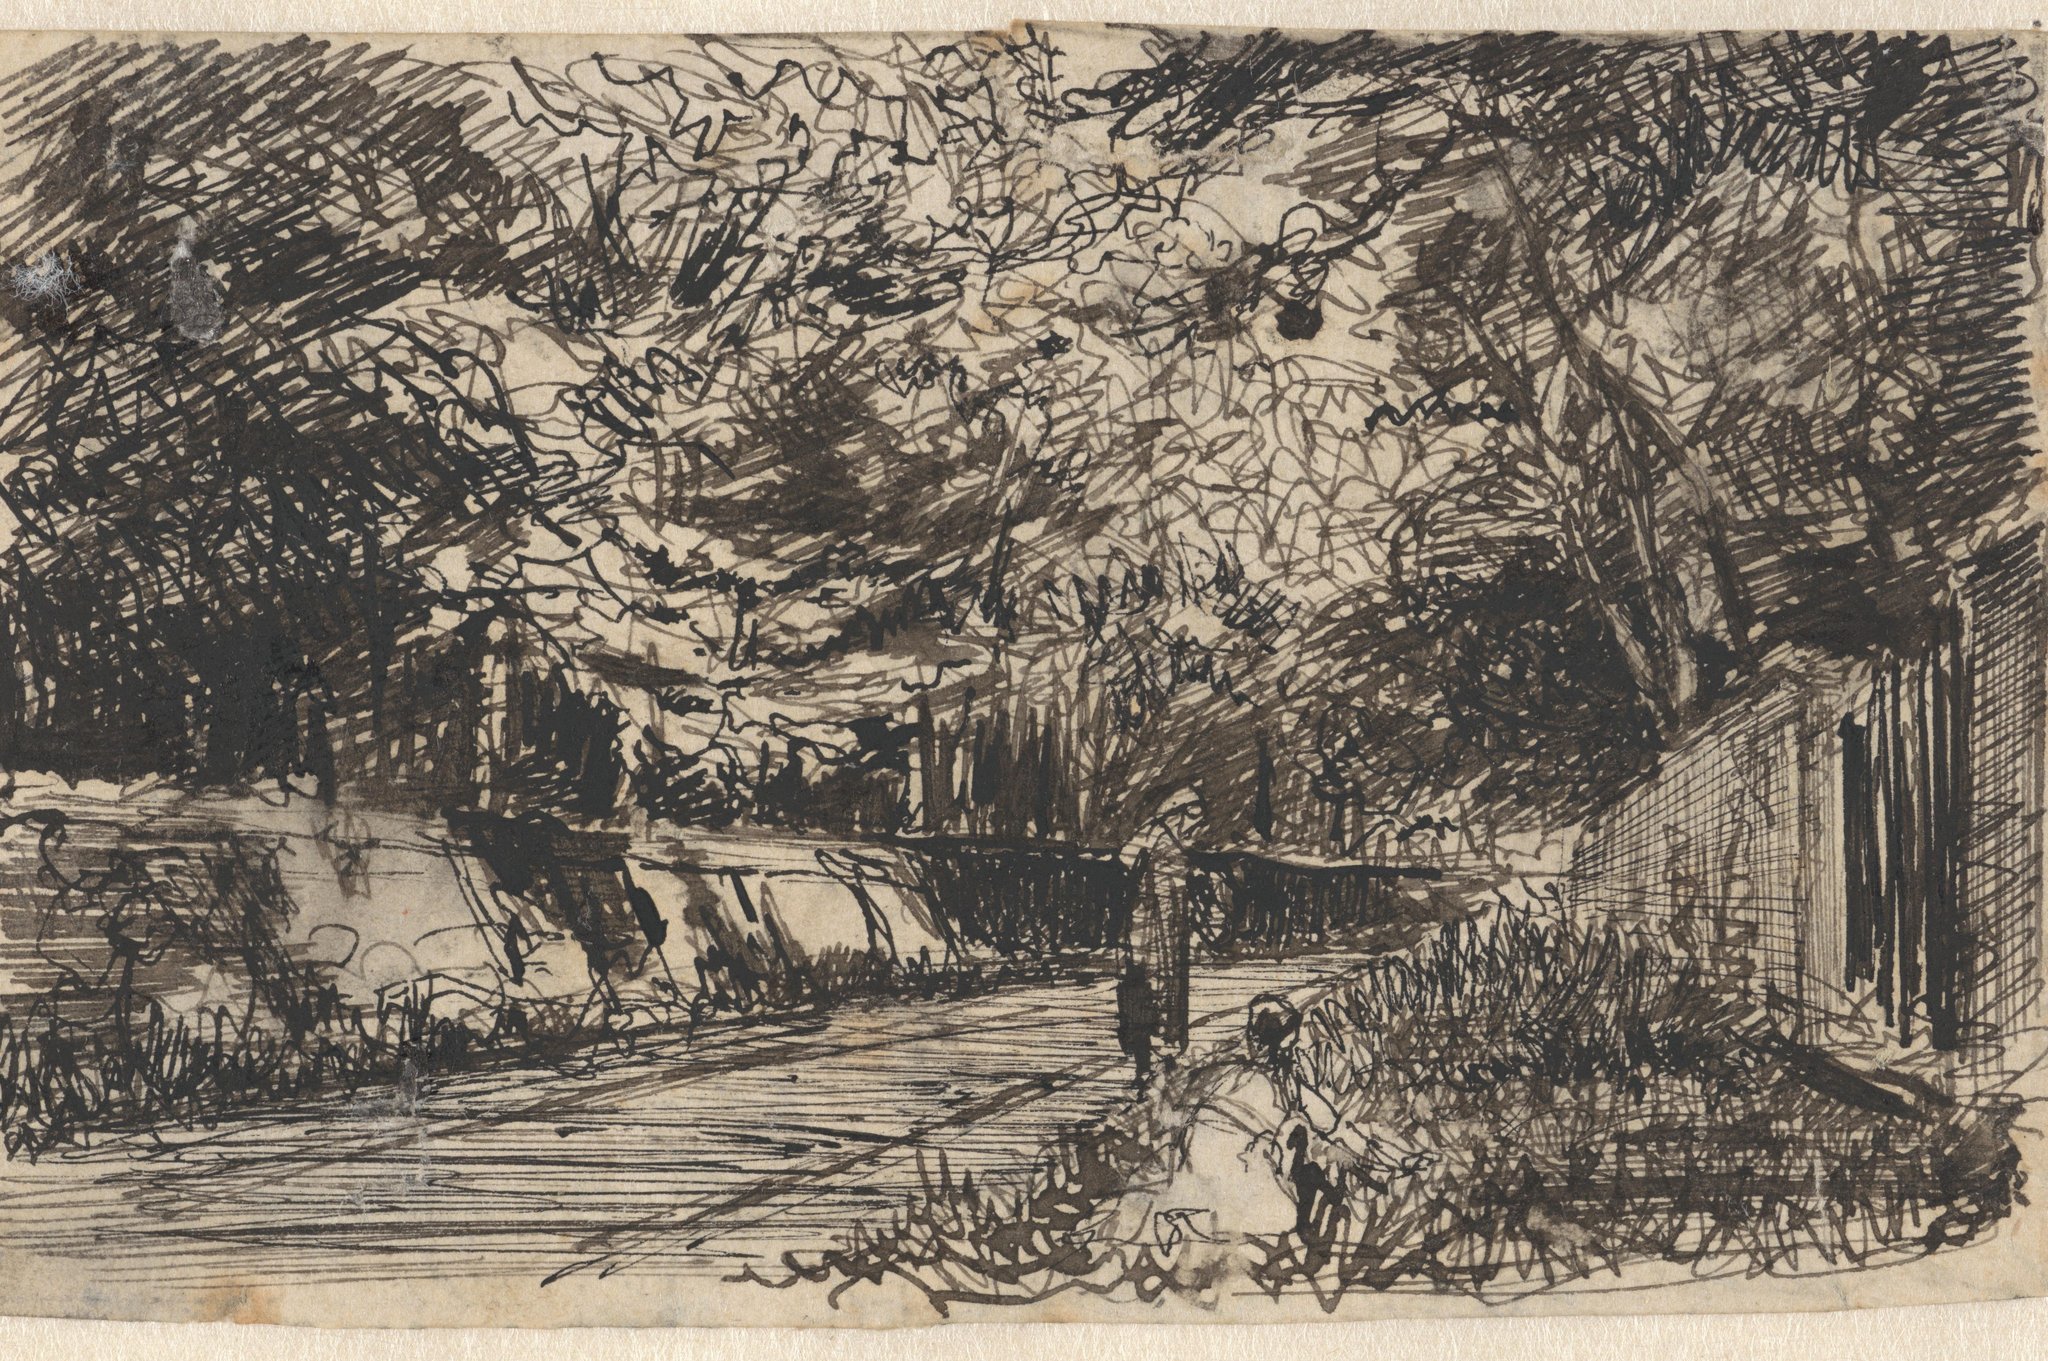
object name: drawing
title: Laan tussen bomen met twee figuren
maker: coen metzelaar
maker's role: draughtsman, painter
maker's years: 1845-1881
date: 1855-1881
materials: ink, paper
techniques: pen